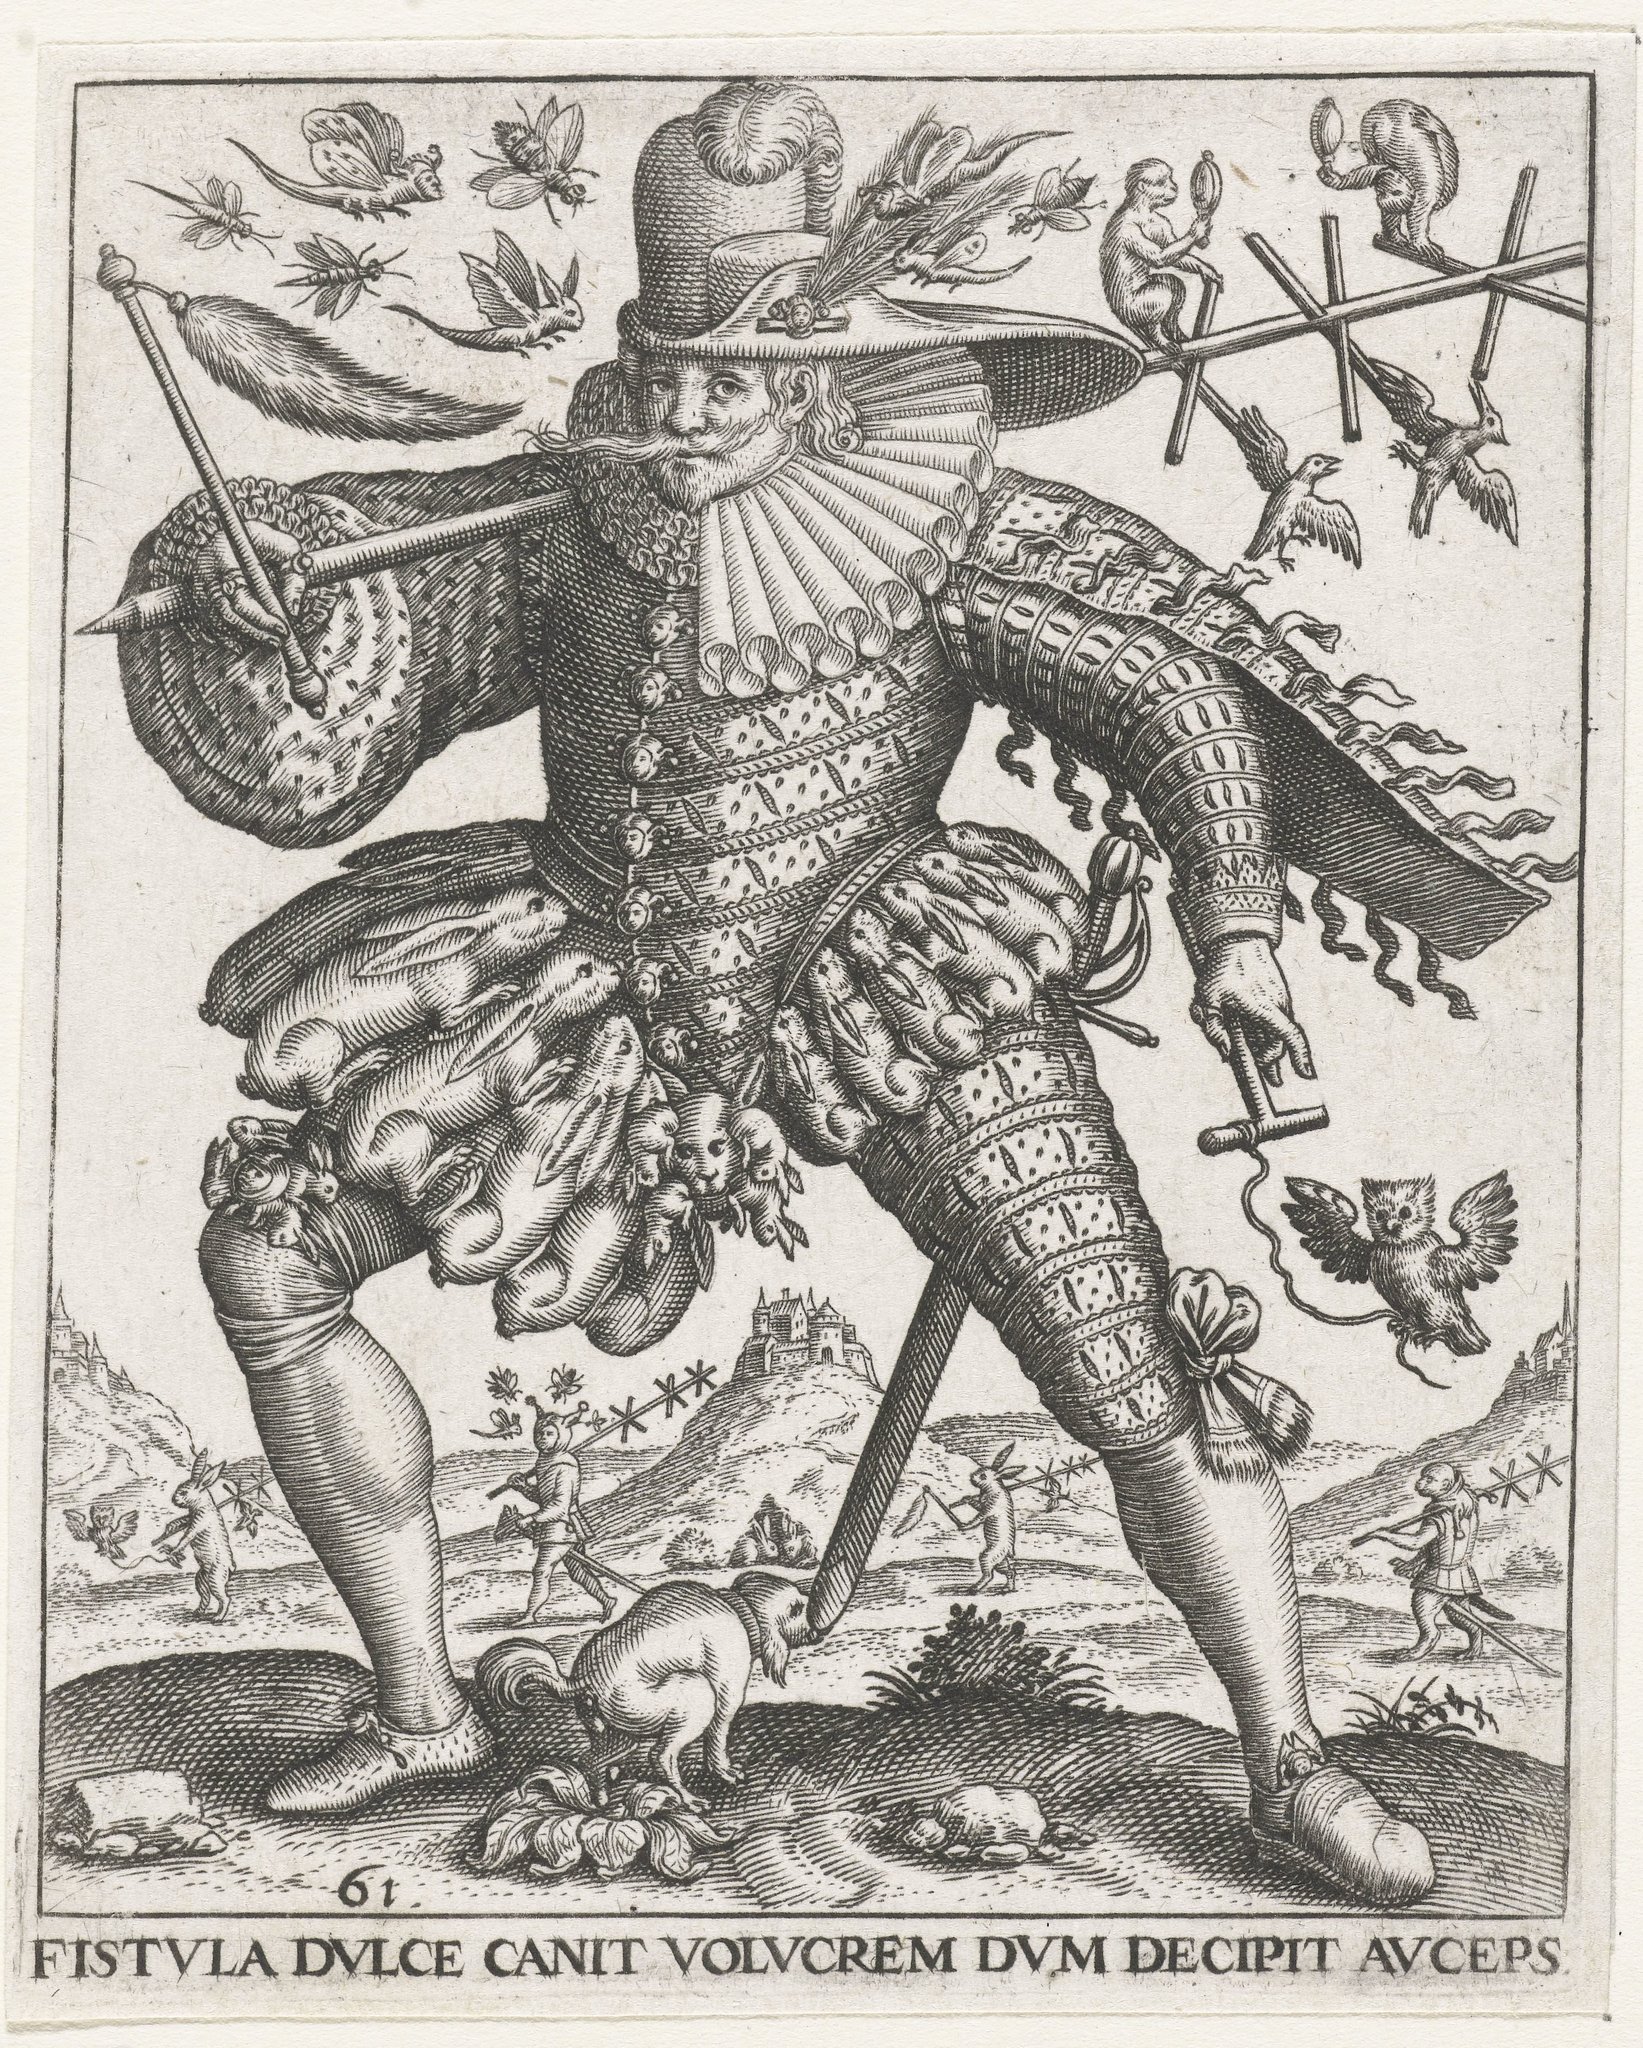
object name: print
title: Emblemata Saecularia, 1596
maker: johann theodor de bry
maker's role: print maker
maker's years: 1561-1623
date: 1596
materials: paper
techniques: engraving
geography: frankfurt am main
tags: existence and modes of existence (+ emblematical representation of concept), fashion, return from the hunt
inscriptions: collector's mark: Lugt 240, inscription: ‘FISTULA DULCE CANIT VOLUCREM DUM DECIPIT AUCEPS’, number: ‘61’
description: Hazenjager in 'mis-parti' (kleding, waarvan de rechterzijde anders is dan de linkerzijde). Op zijn hoofd een hoge hoed met rechts een brede rand. Om zijn middel hangen hazen. In de rechterhand houdt hij een vossenstaart en over zijn schouder een lange lijmstok waarop vogels zitten vastgekleefd en kleine aapjes zitten. In de linkerhand heeft hij een stokje met een uiltje. Om zijn hoofd zwermen insecten. Op de grond een poepend hondje. Op de achtergrond een nar, een aap en twee hazen als 'vogelvangers'. Persiflage op de grillen van de eigentijdse mode. Embleem nr. 16 in Emblemata Saecularia, 1596 (op de prent is het nummer abusievelijk omgedraaid) en nr. 37 in de tweede uitgave van 1611.